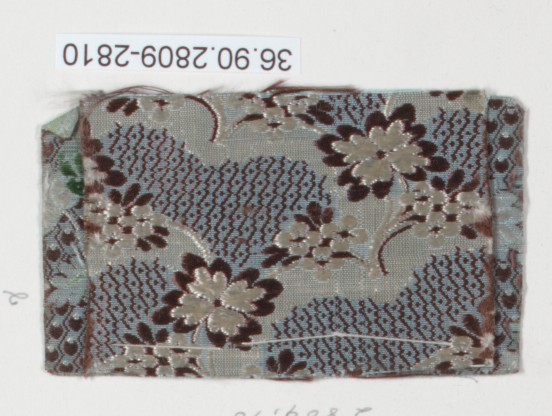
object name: piece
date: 1801-1900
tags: flowers